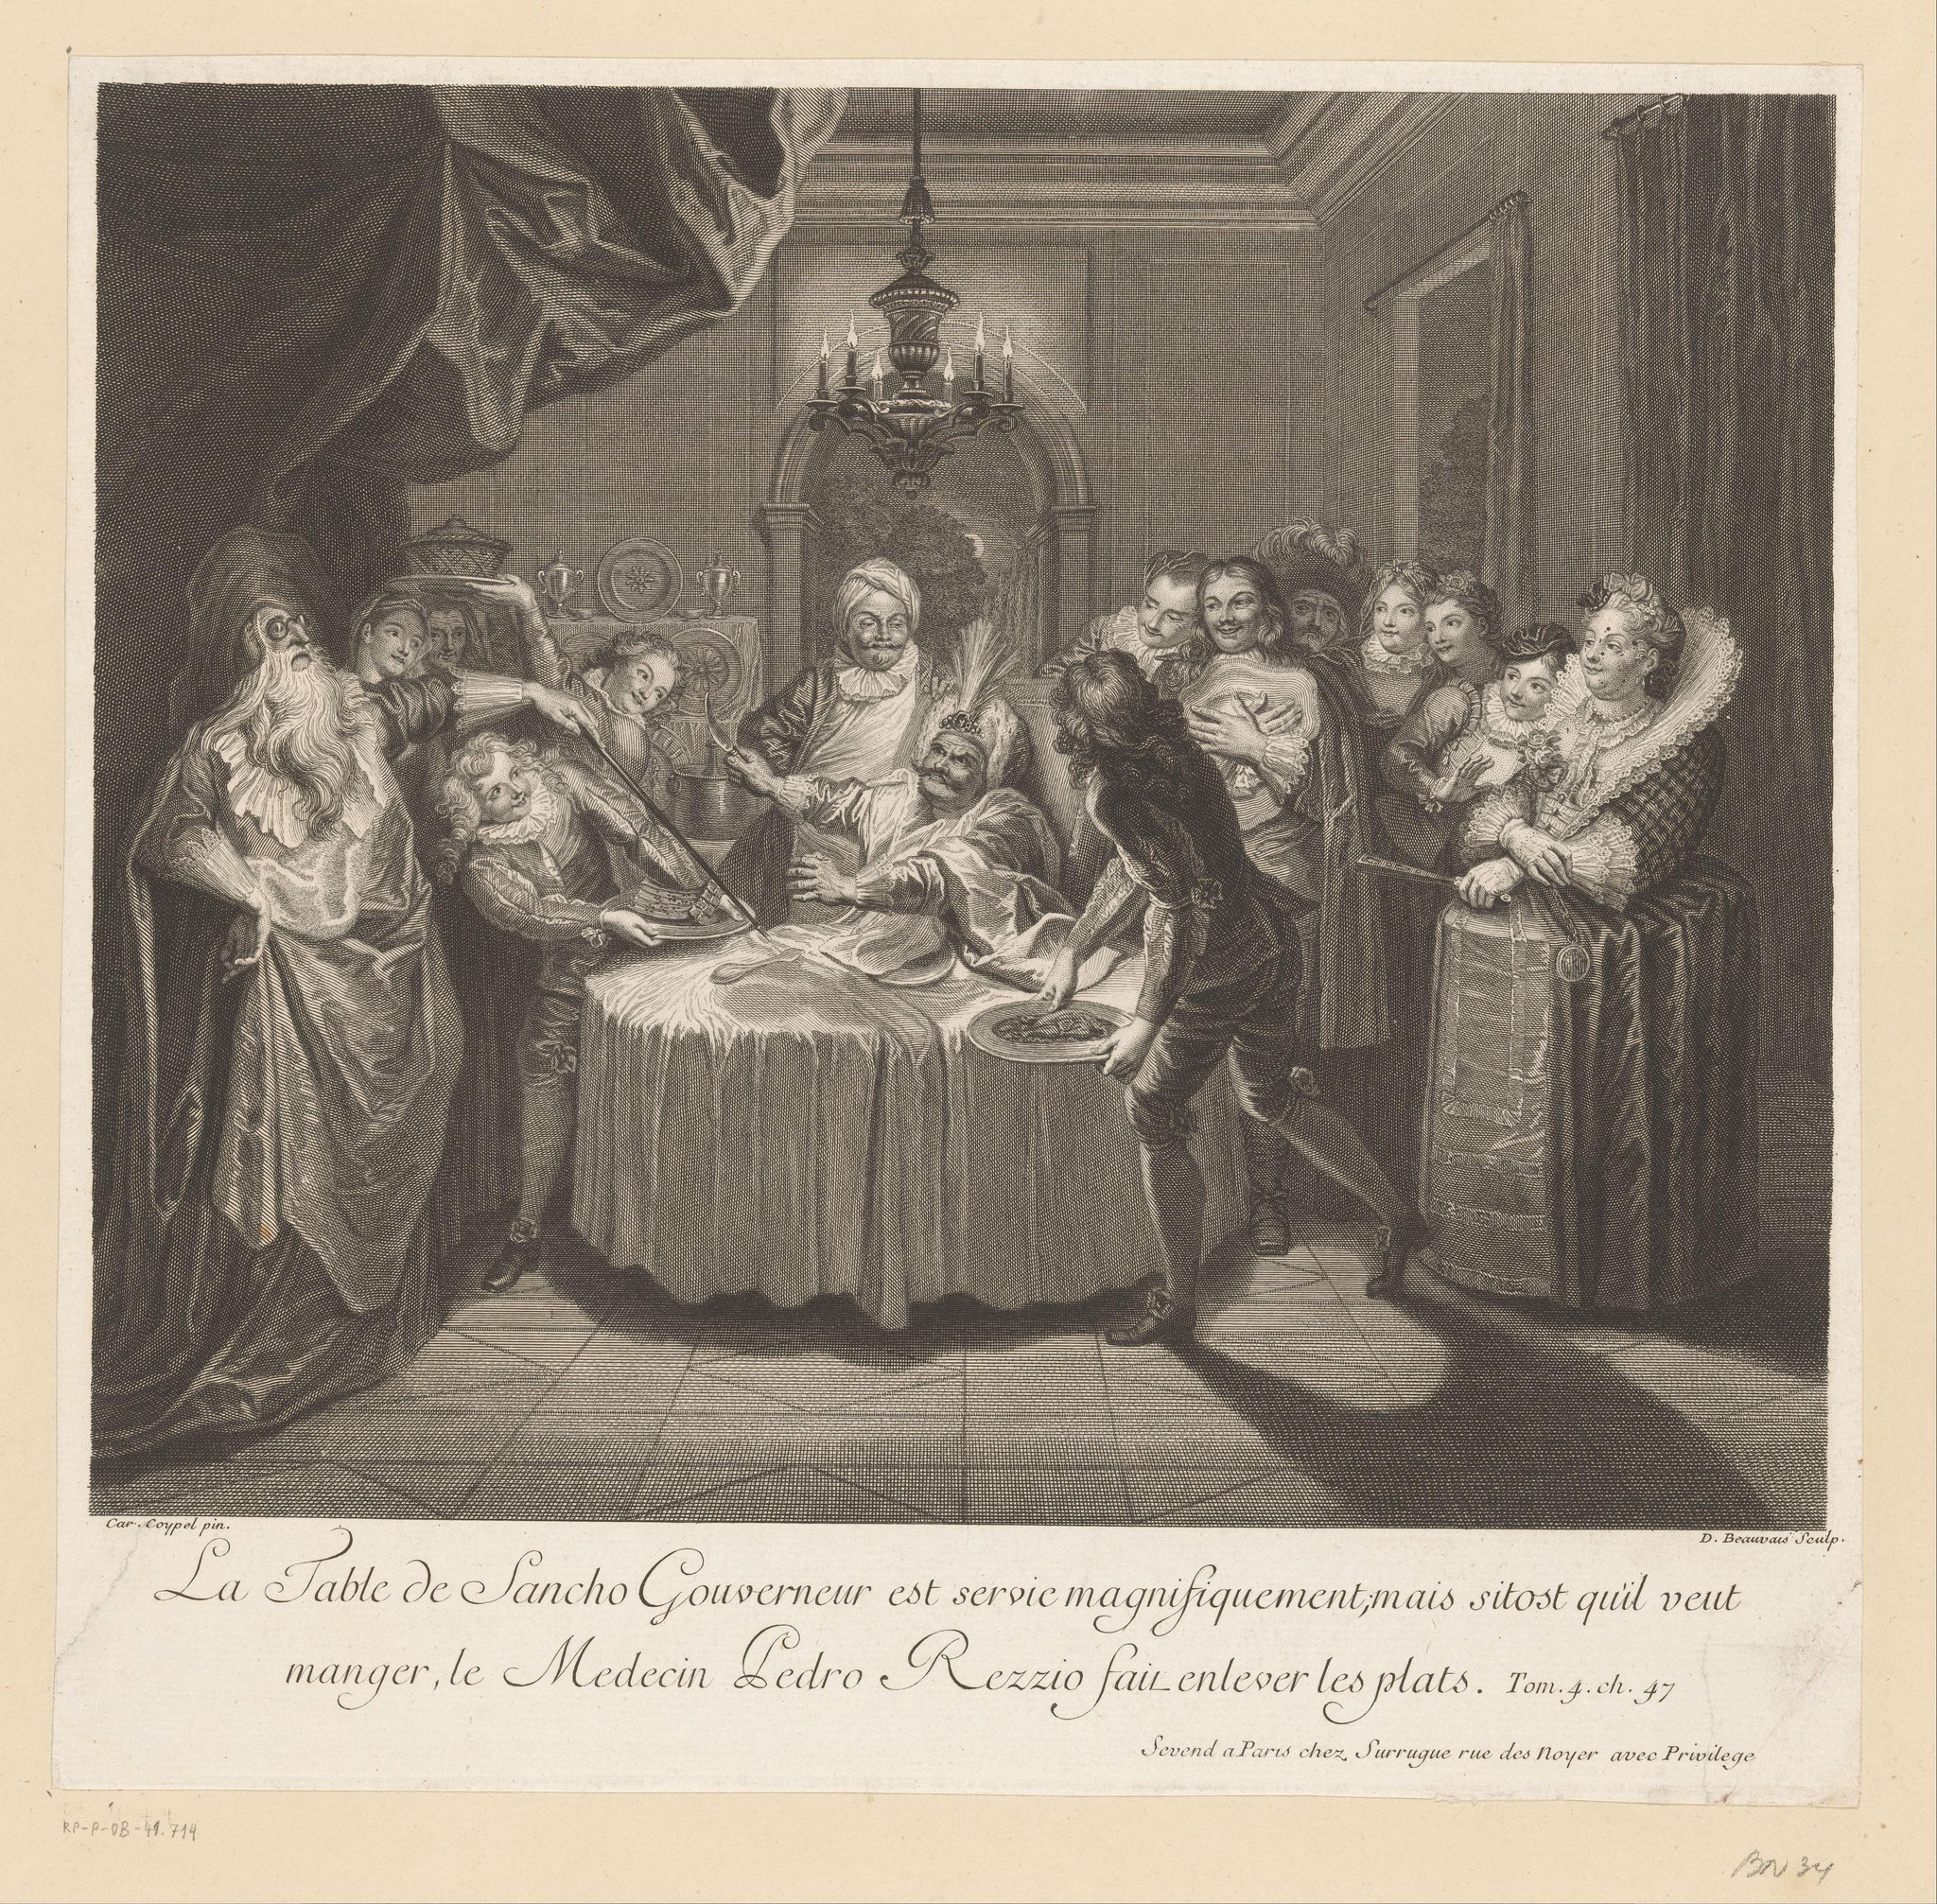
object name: print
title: Protest van Sancho Panza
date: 1704-1762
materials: paper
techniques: engraving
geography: paris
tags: protest, physician, doctor, sancho panza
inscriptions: collector's mark: Lugt 240